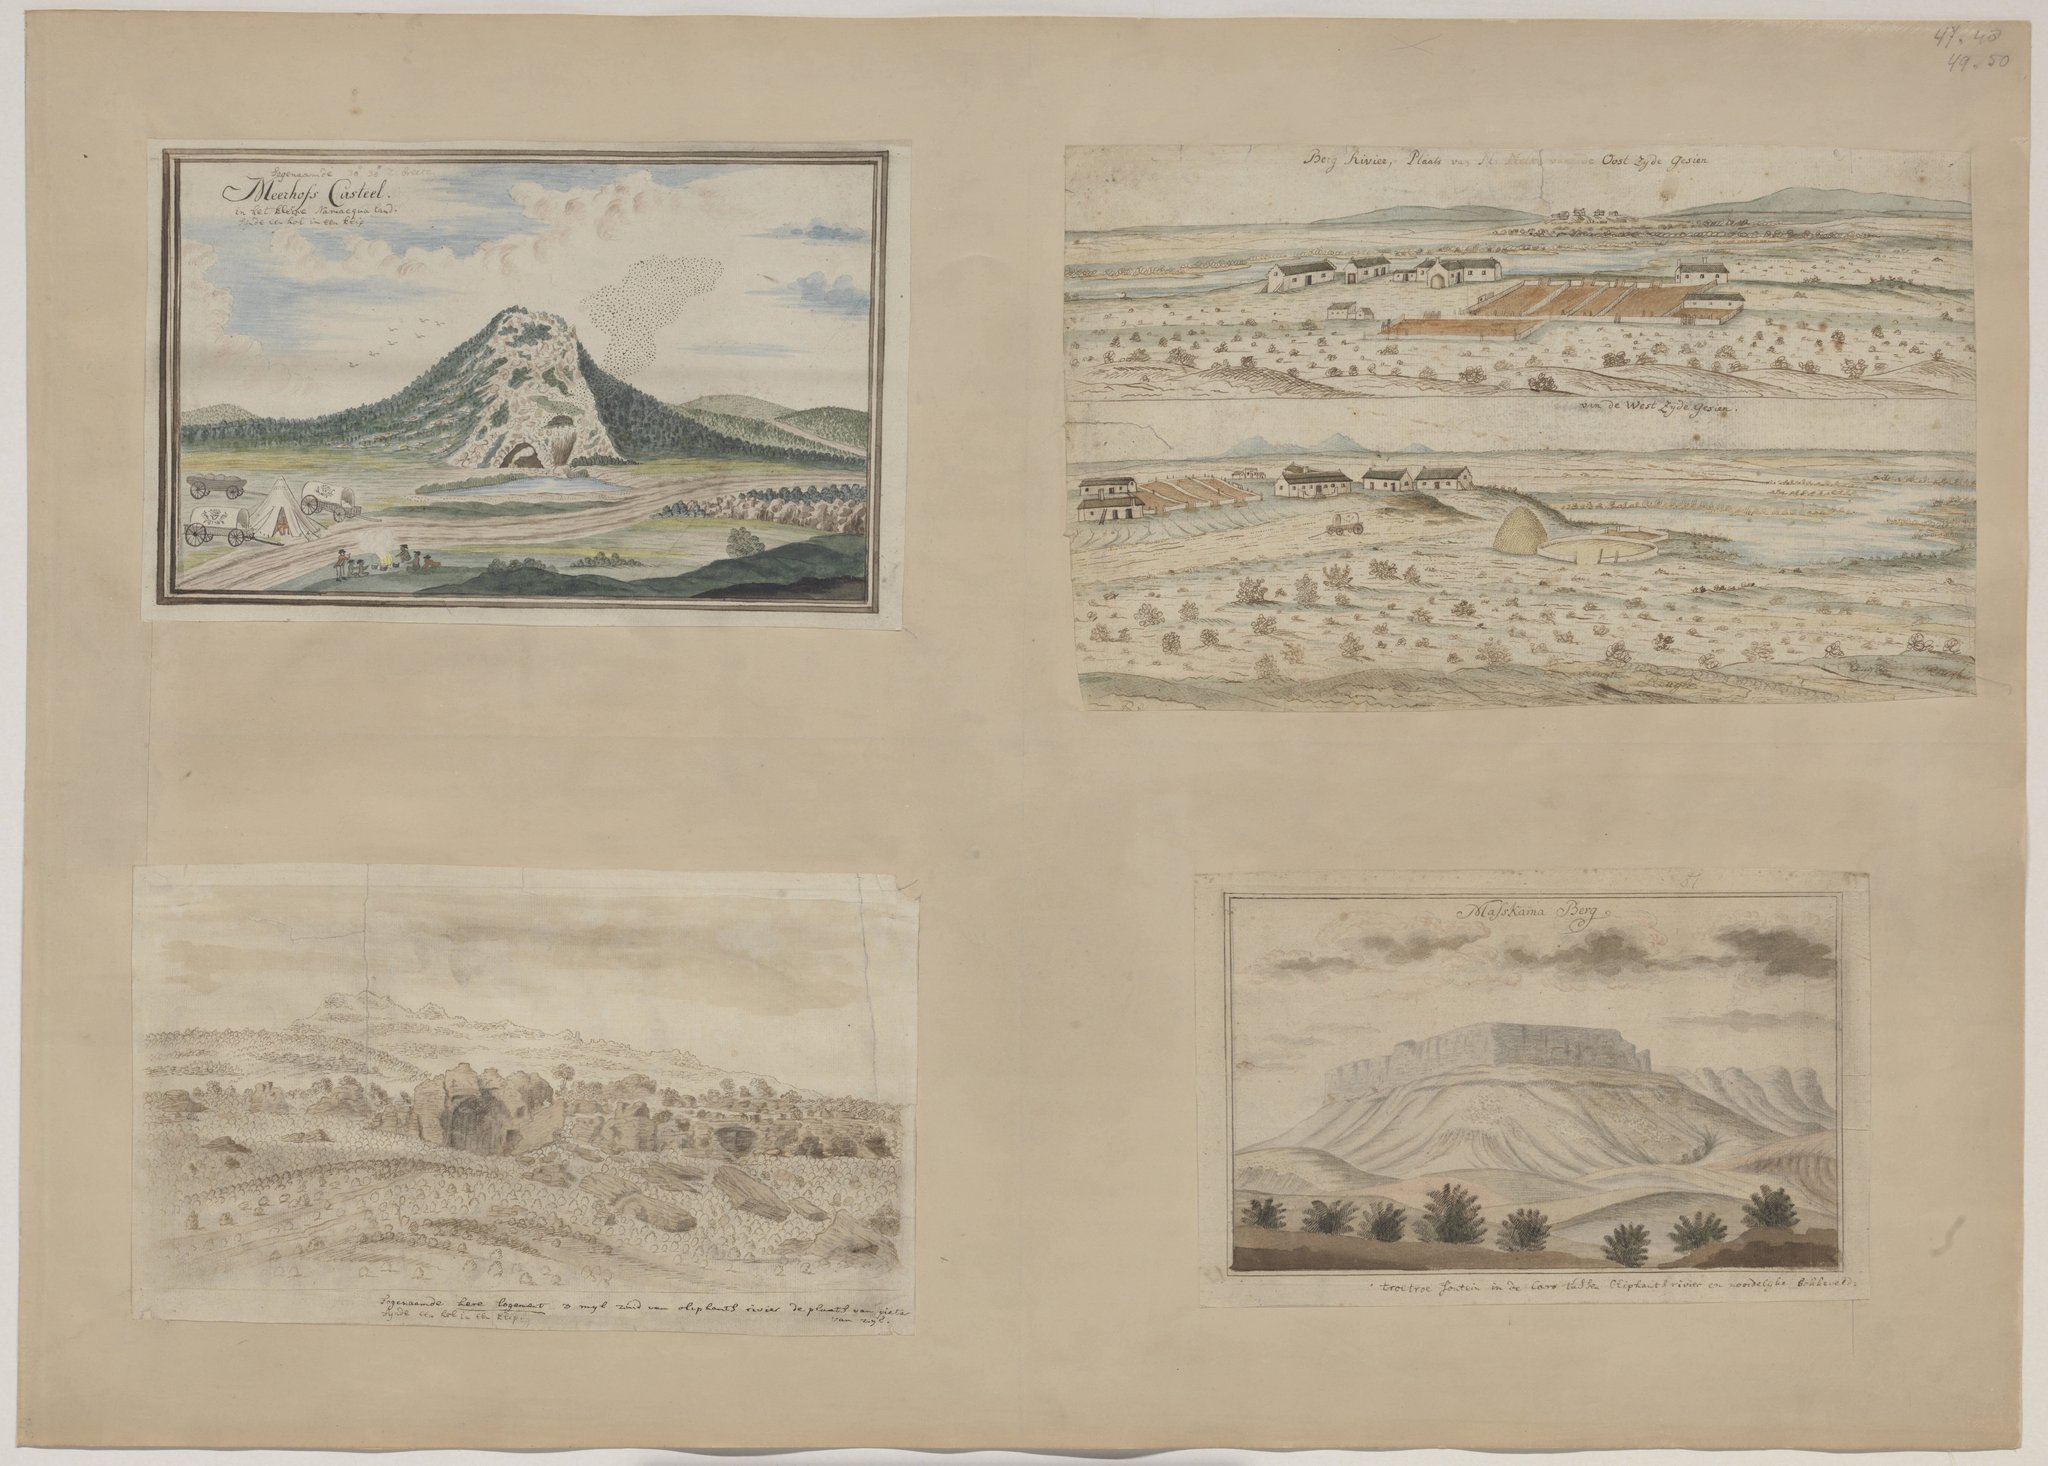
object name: topographical view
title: Meerhoff's Kasteel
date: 1779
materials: ink, paper, pencil, watercolor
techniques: brush, pen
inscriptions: annotation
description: Een bergformatie met een gat in de rots, nabij Draaihoek, in Klein Namaqualand; de grote zwerm bijen is beschreven in het Journaal.